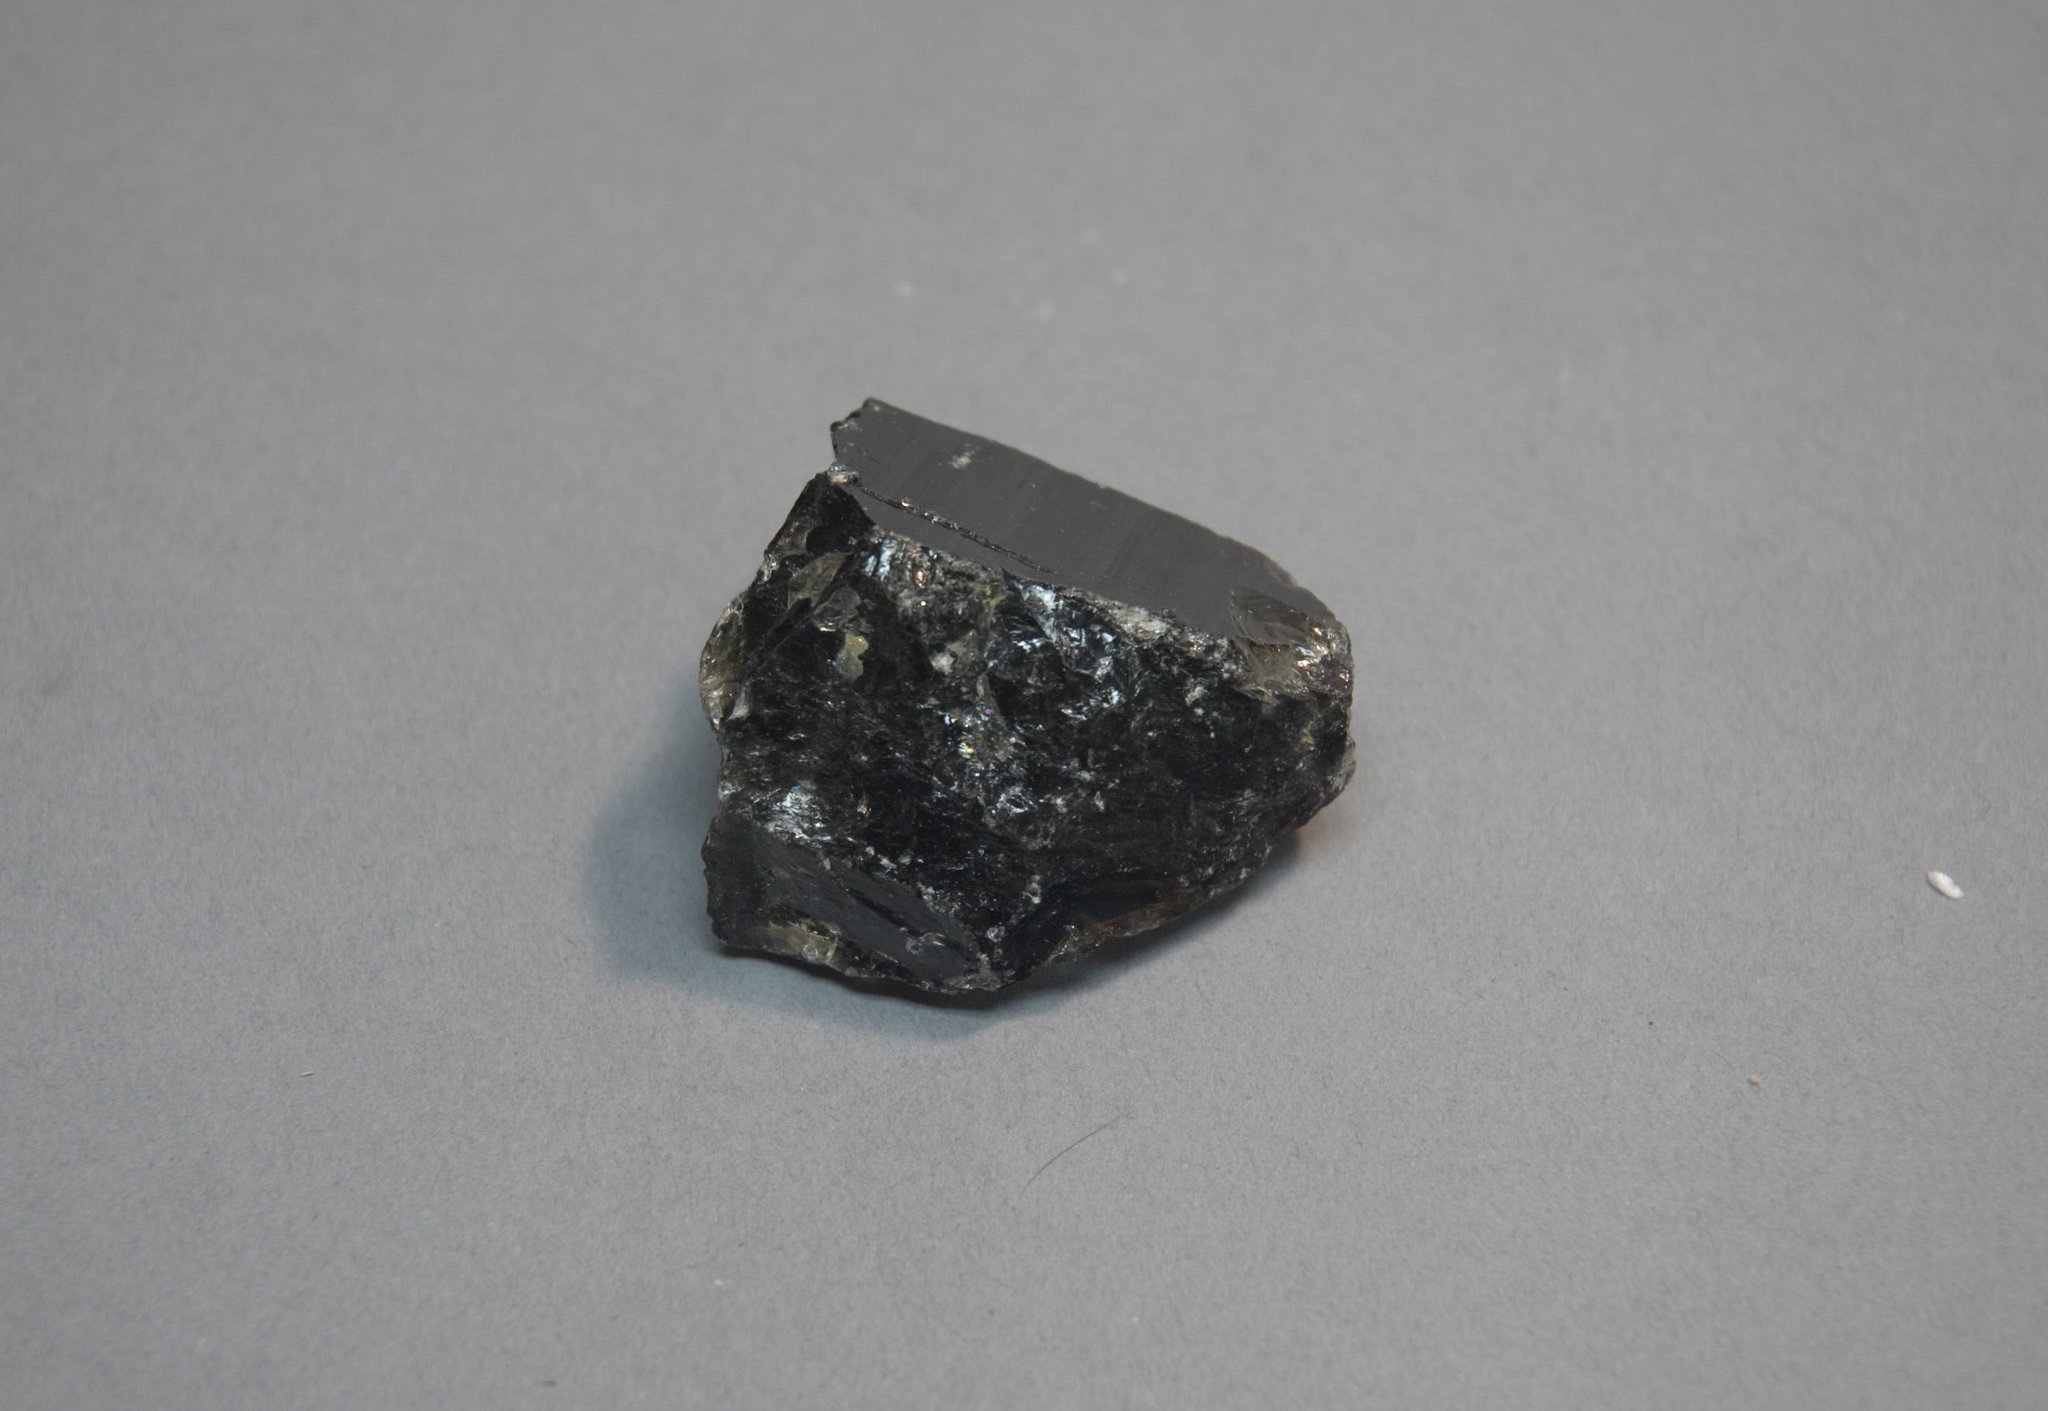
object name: jade carving material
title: Sample of Smoky Quartz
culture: chinese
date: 1901-2000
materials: quartz